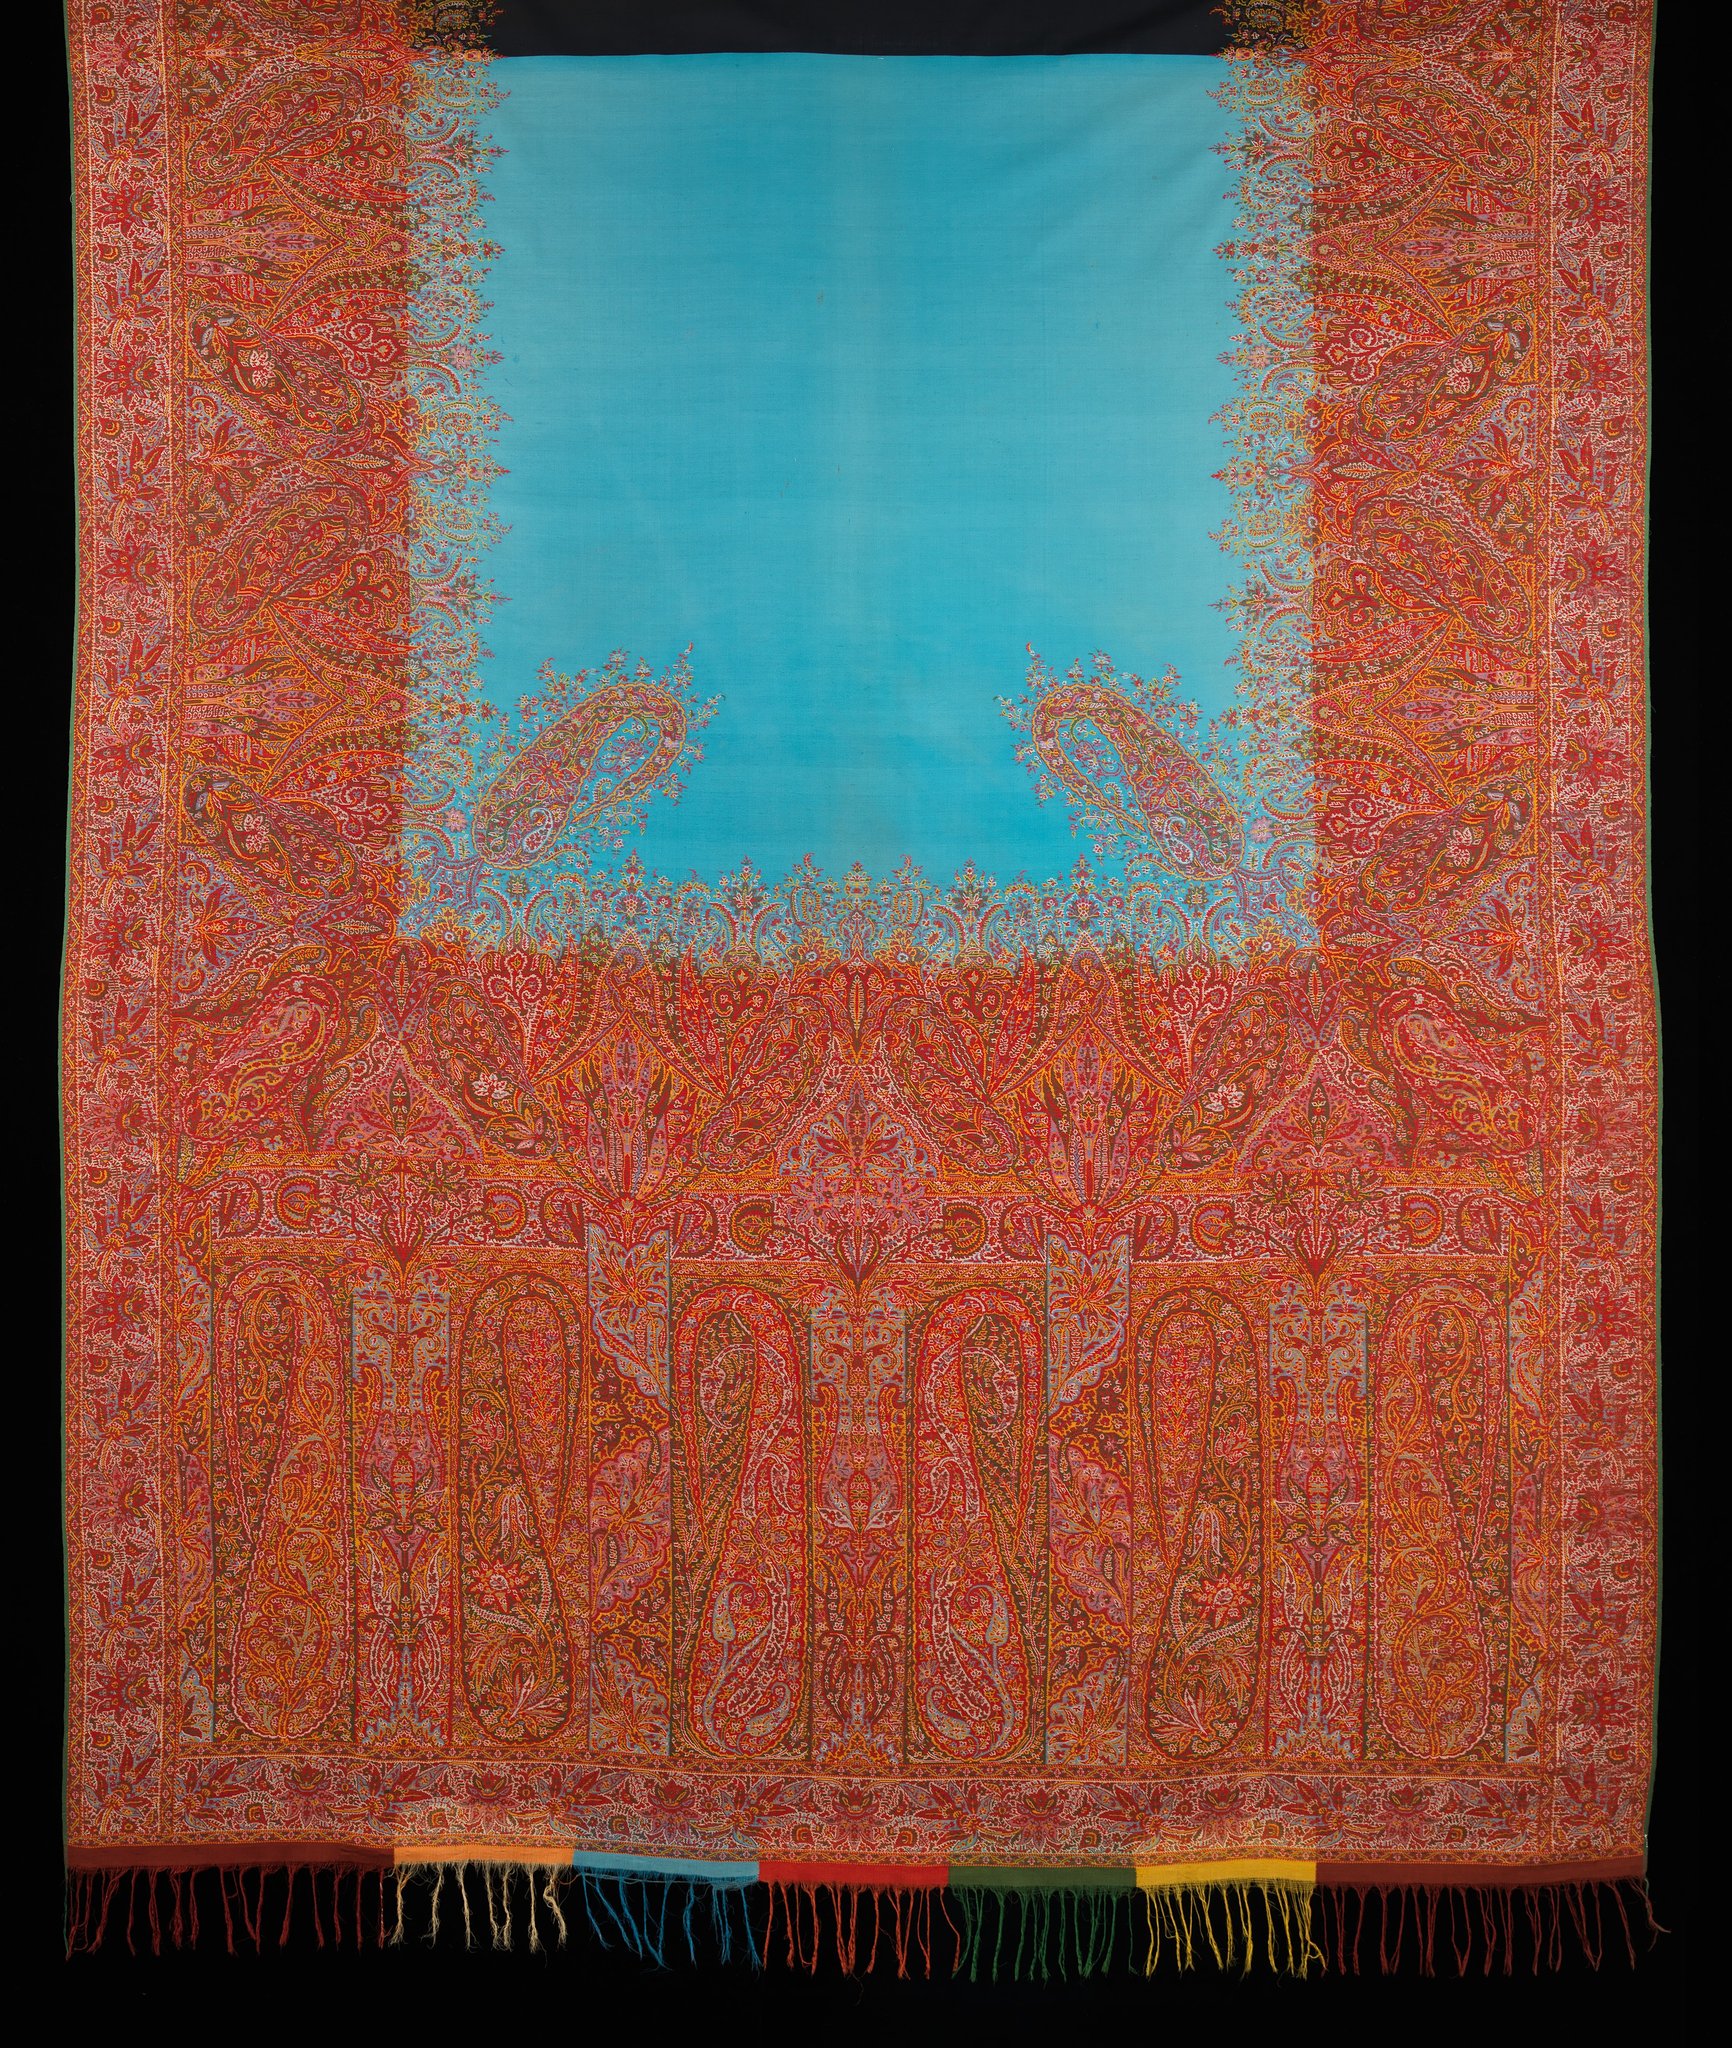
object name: shawl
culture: scottish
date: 1860-1869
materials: cotton, wool